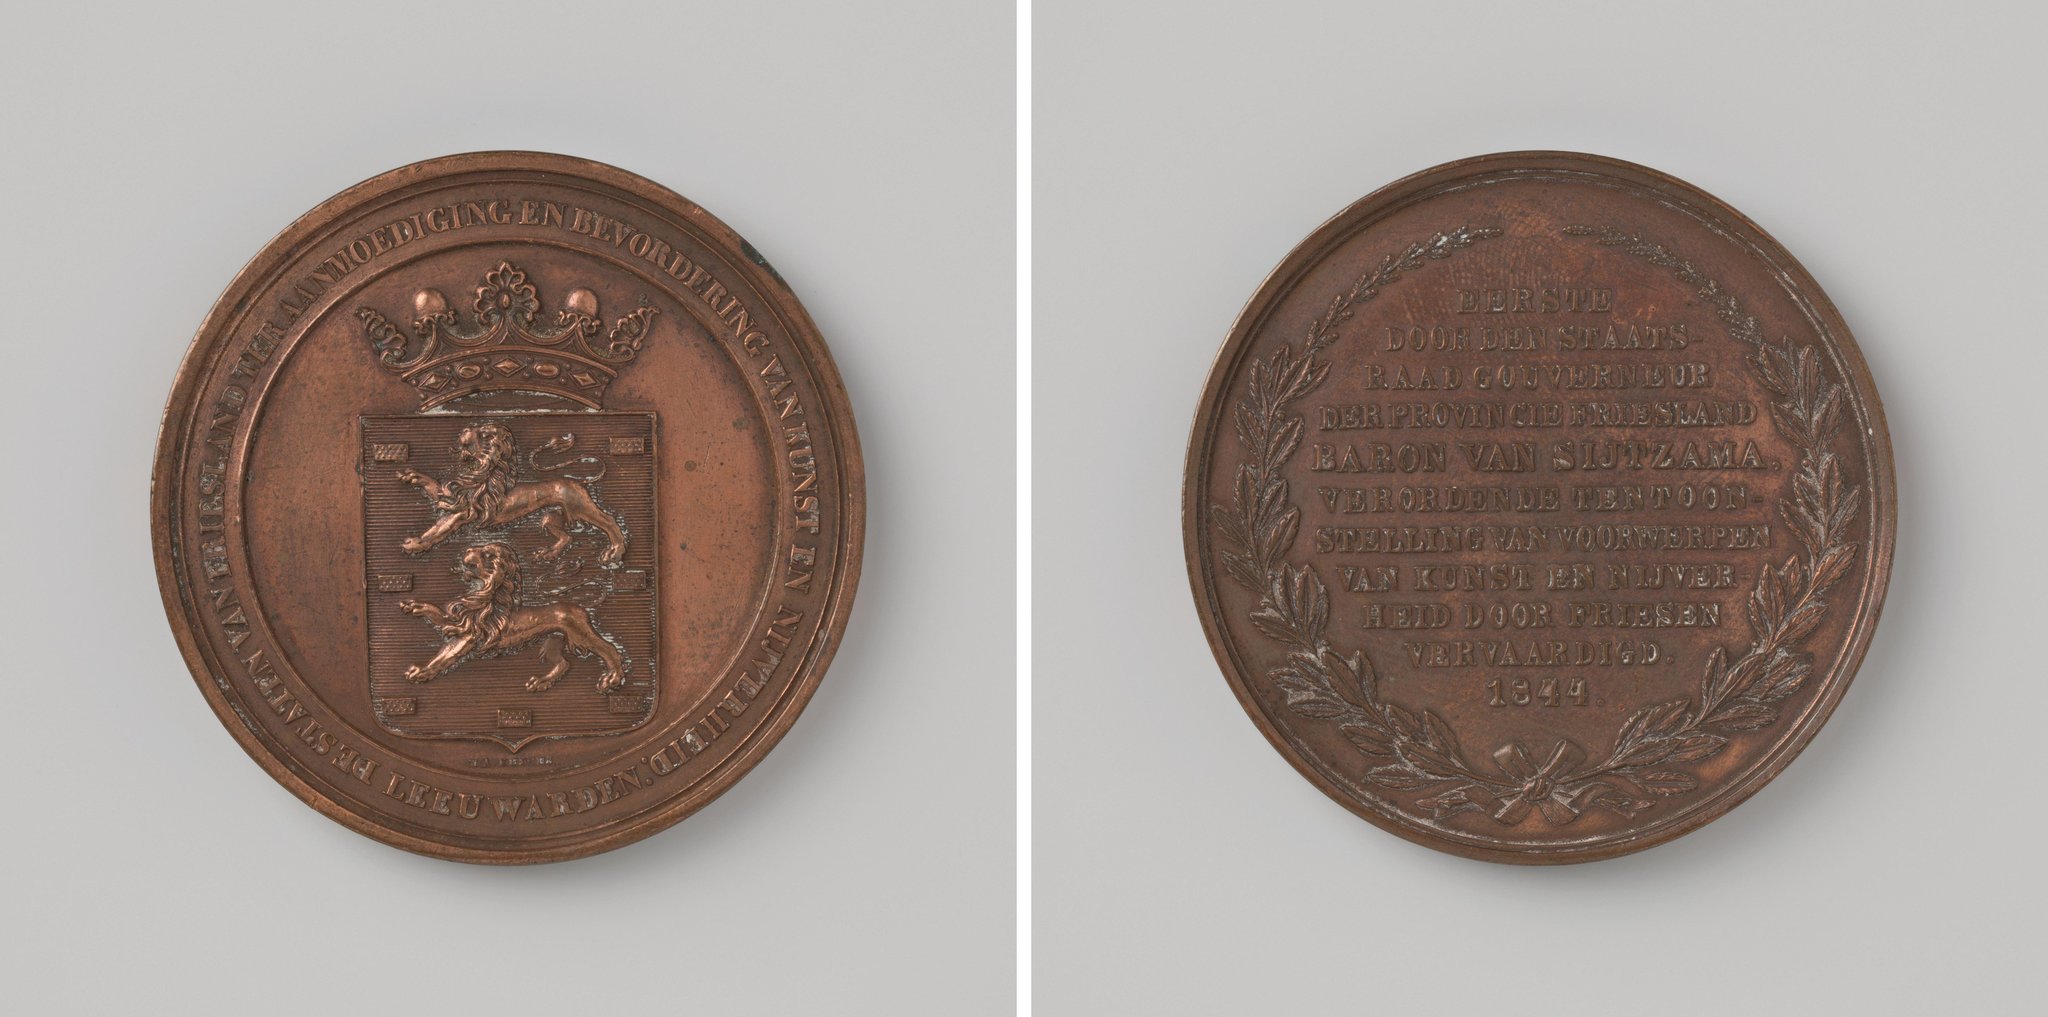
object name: history medal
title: Tentoonstelling van voorwerpen van kunst en nijverheid door Friezen vervaardigd 1844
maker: tjeerd keikes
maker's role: medailleur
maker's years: 1804-1886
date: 1844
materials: bronze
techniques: striking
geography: leeuwarden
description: Bronzen penning, op de voorzijde het gekroonde wapen van Friesland met omschrift, op de keerzijde elf regels tekst tussen samengestrikte lauwertakken.